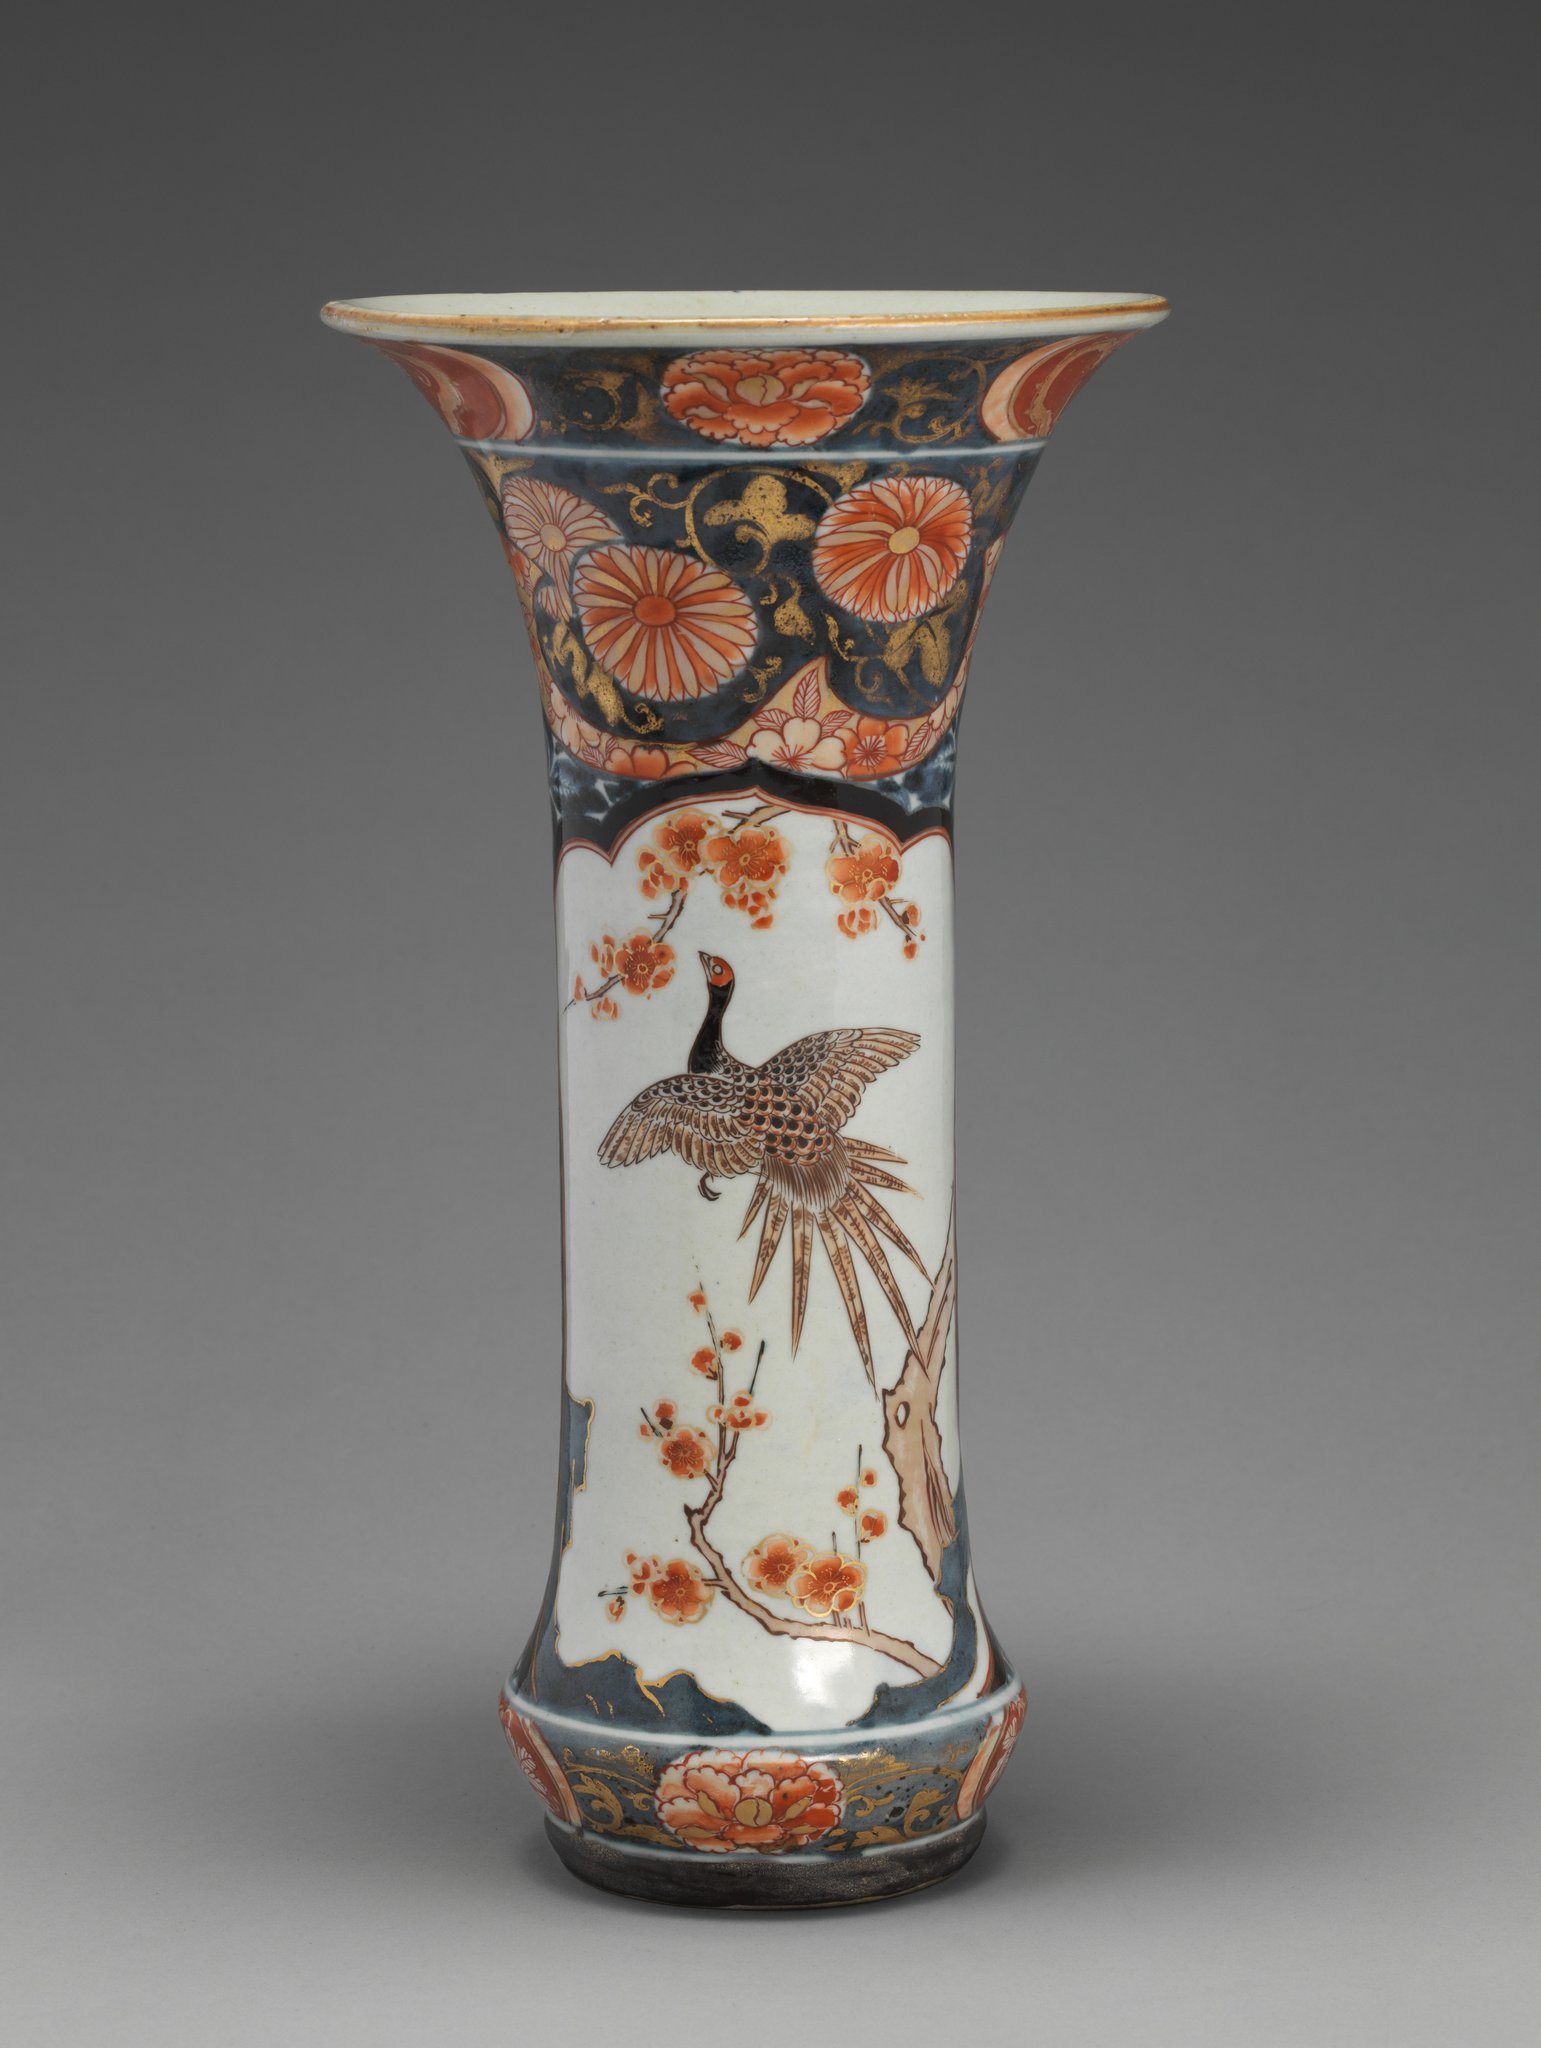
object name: vase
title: Beaker vase (part of a five-piece garniture)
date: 1690-1720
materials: enamel, hard paste porcelain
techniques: gilding, overglaze, underglaze